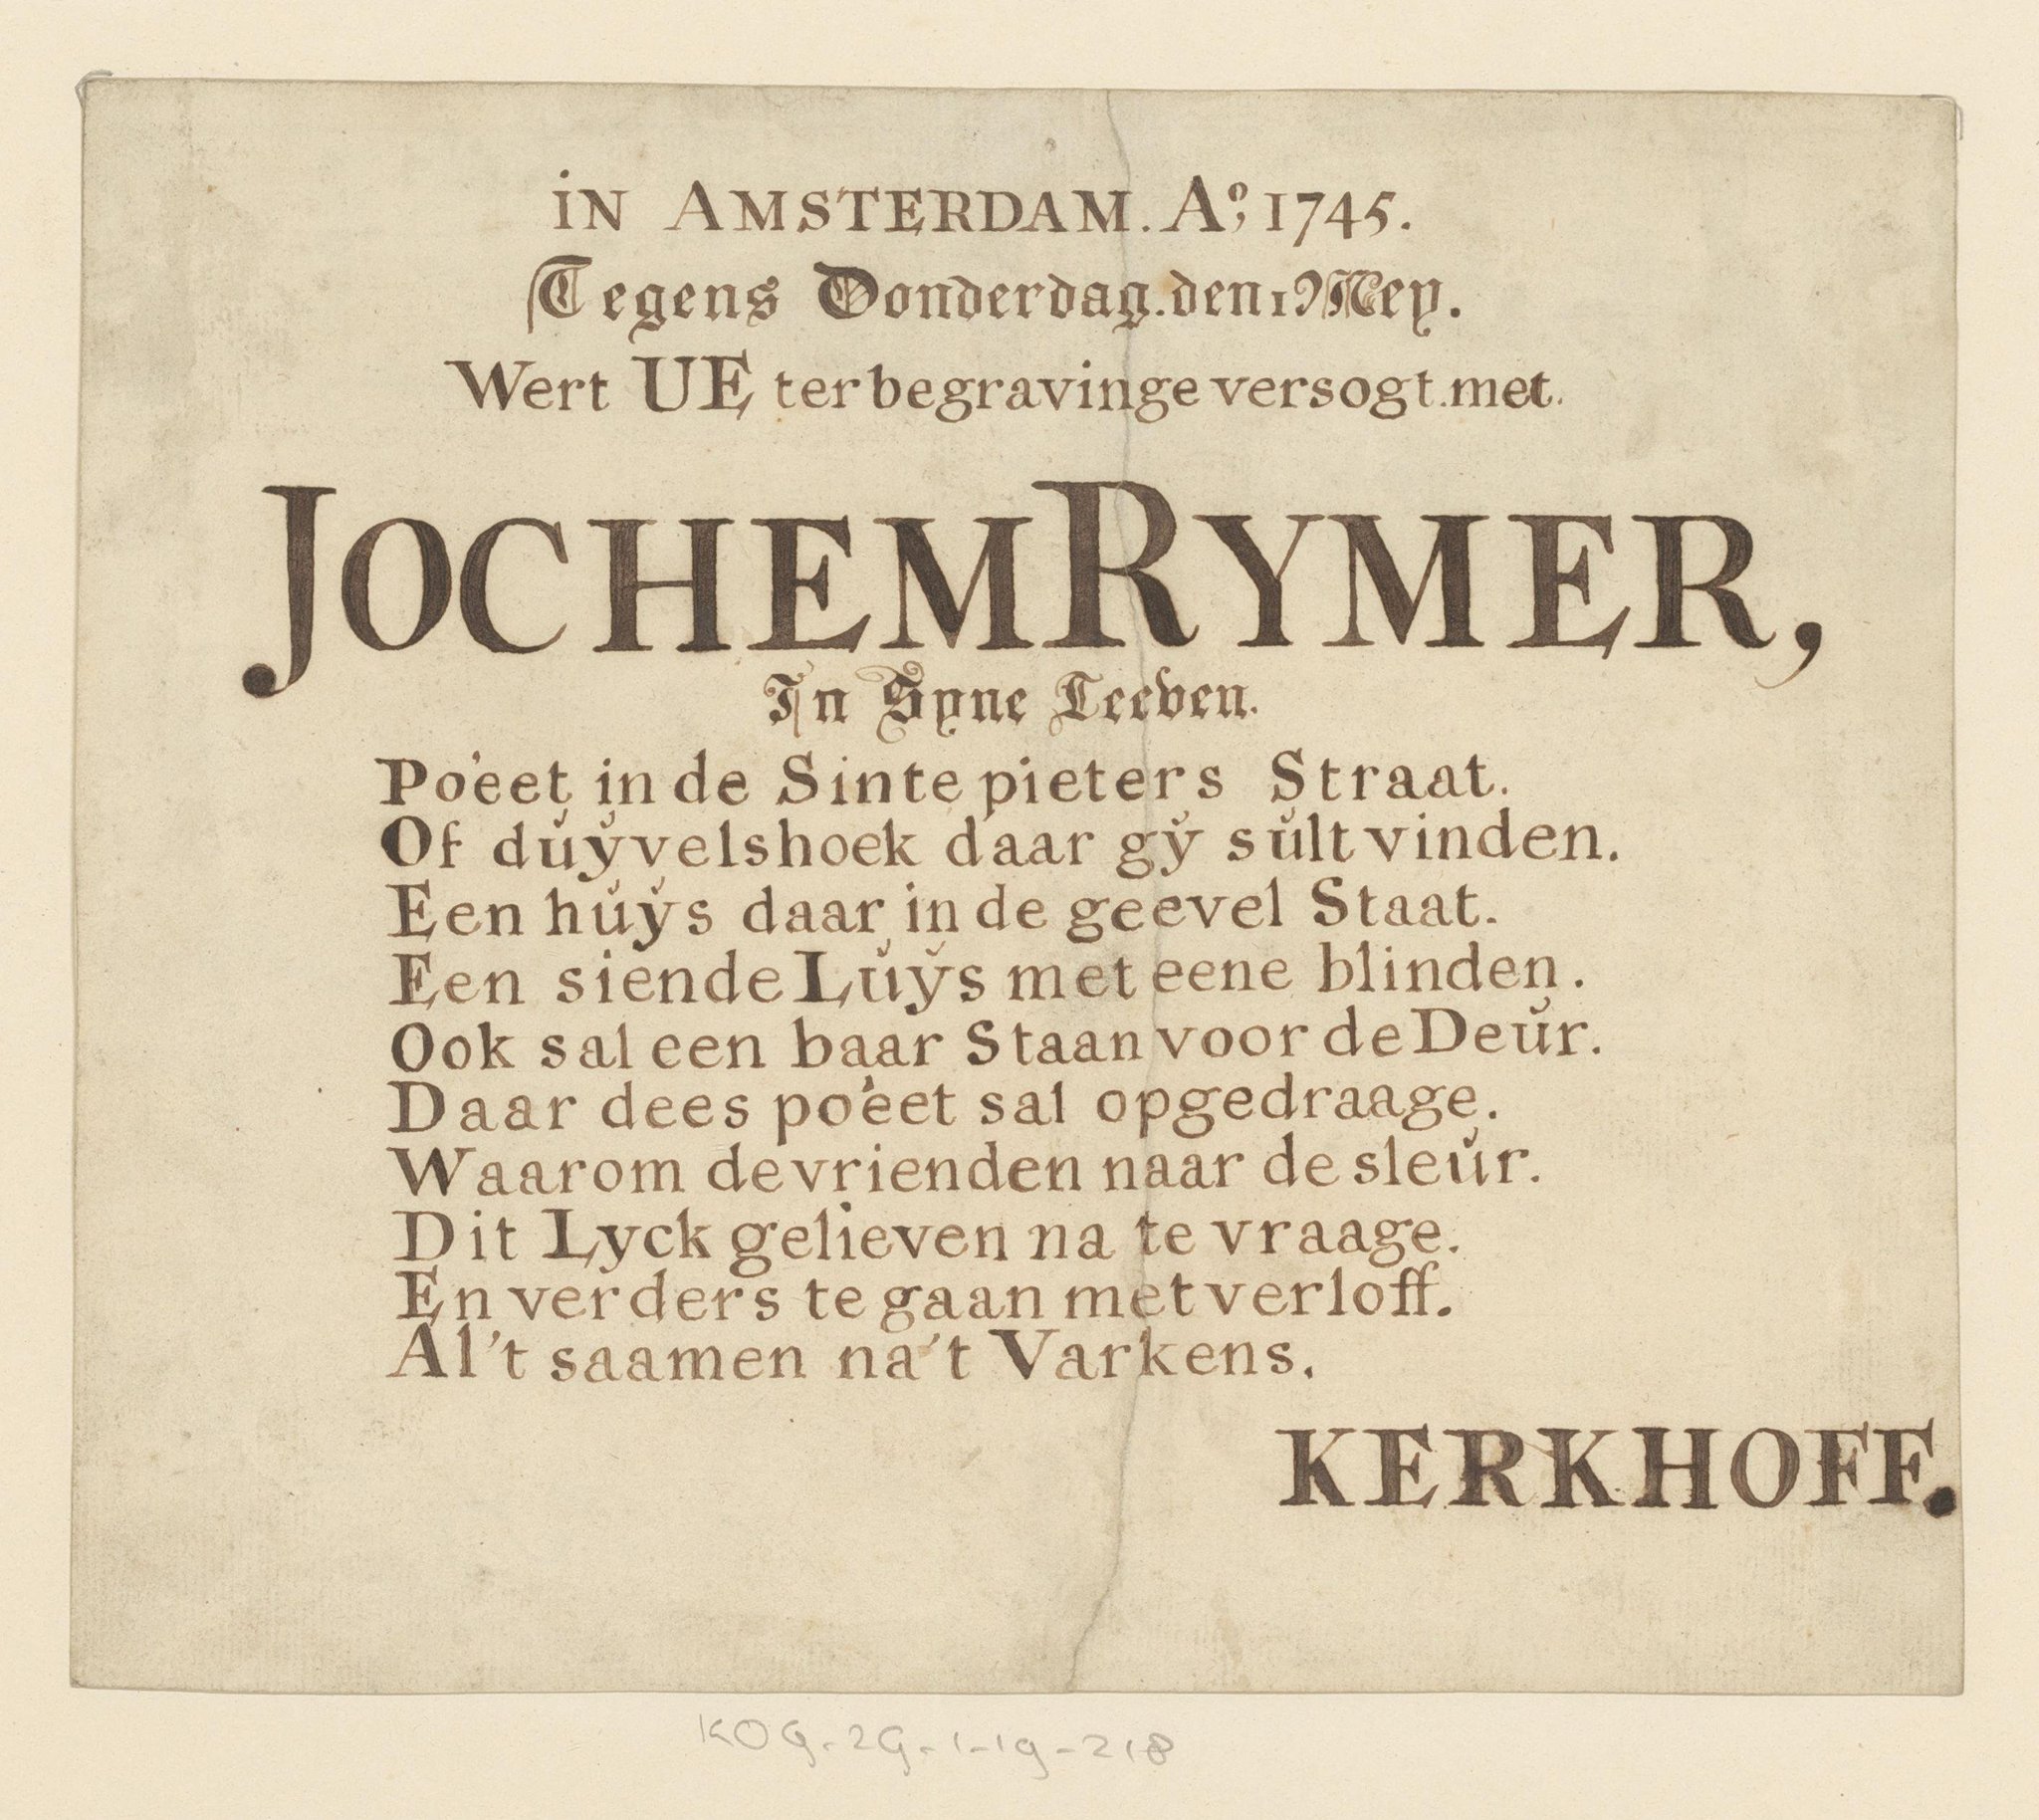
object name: invitation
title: Handgeschreven begrafenisbriefje van Jochem Rymer, 1 mei 1745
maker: Anonymous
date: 1704-1745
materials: ink, paper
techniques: pen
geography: amsterdam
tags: mourning card, death notice, obituary, amsterdam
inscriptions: collector's mark: Lugt 1641, collector's mark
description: Handgeschreven begrafenisbriefje met de uitnodiging voor de begrafenis van de dichter Jochem Rymer, op 1 mei 1745, te Amsterdam. Satirisch verzinsel. Onderwerpsrubrieken binnen de Atlas Zeden en Gewoonten: Des Menschen Begin, Midden en Einde. Begrafenissen, begrafenisbriefjes.